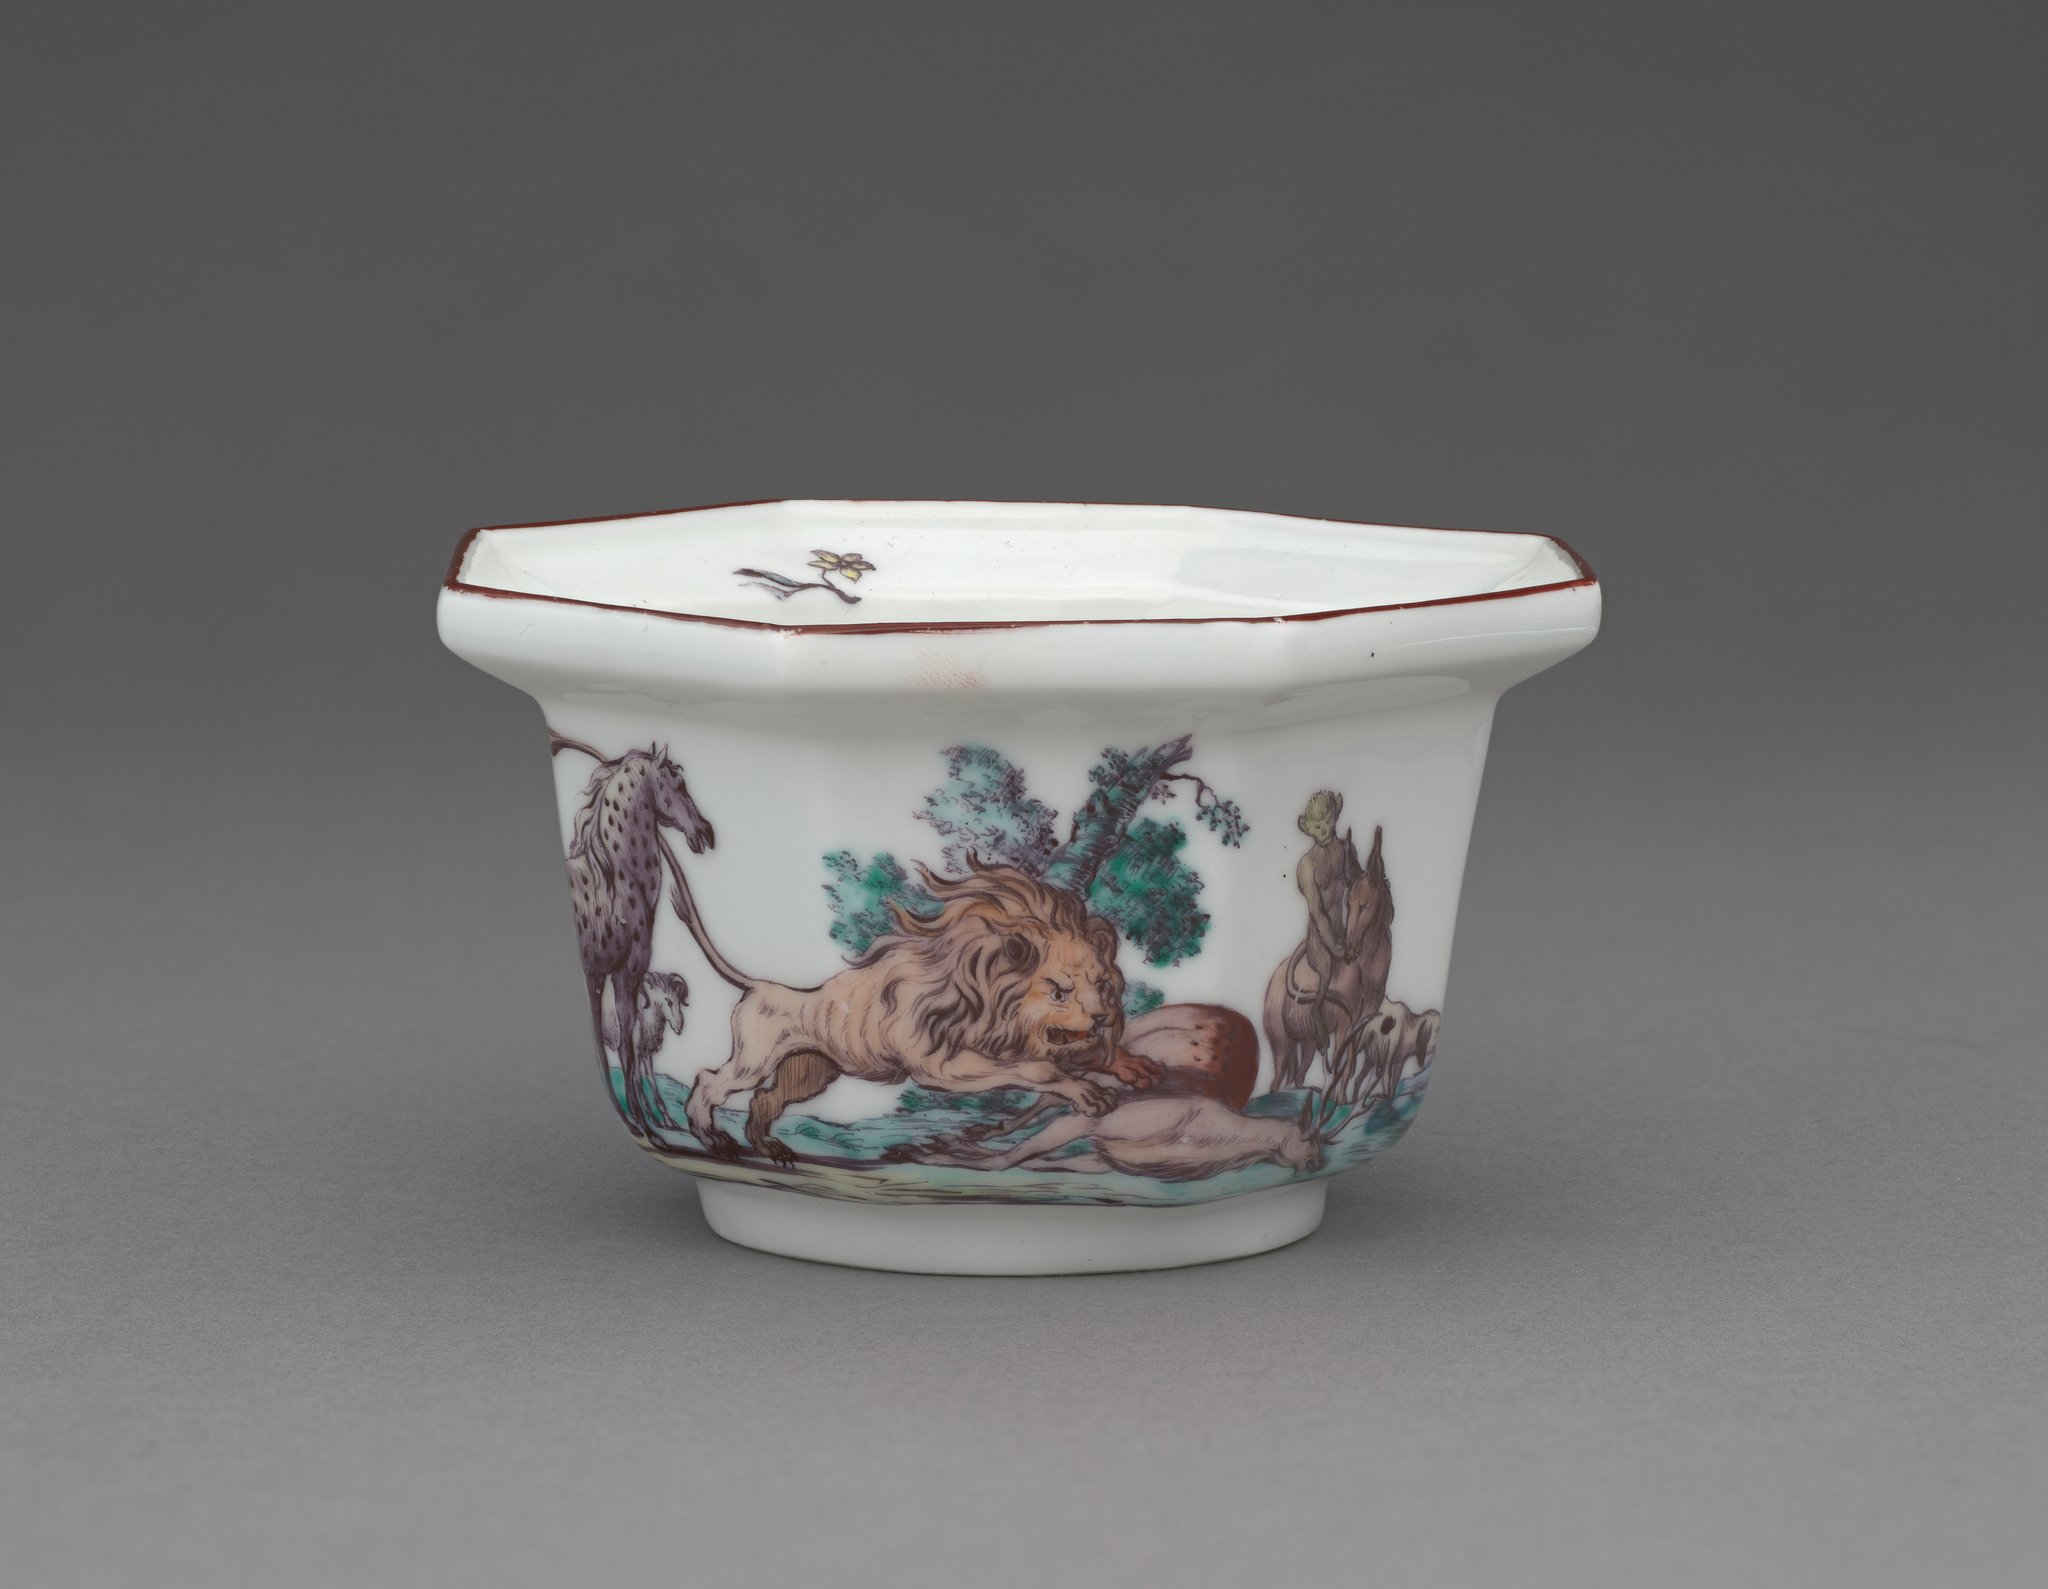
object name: bowl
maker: chelsea porcelain manufactory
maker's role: factory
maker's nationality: british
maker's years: 1744-1784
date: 1752-1755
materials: soft paste porcelain